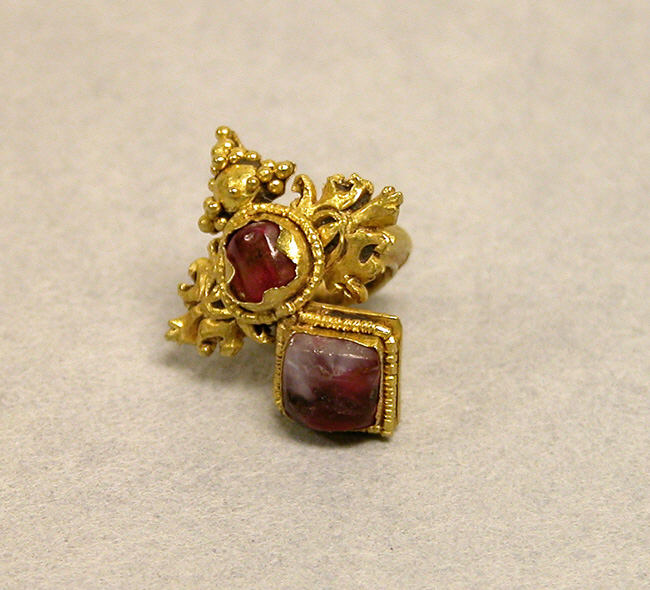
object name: pair of ear ornament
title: Pair of Ear Ornaments, Two-Section Ruby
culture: indonesian, central java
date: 701-1200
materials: gold